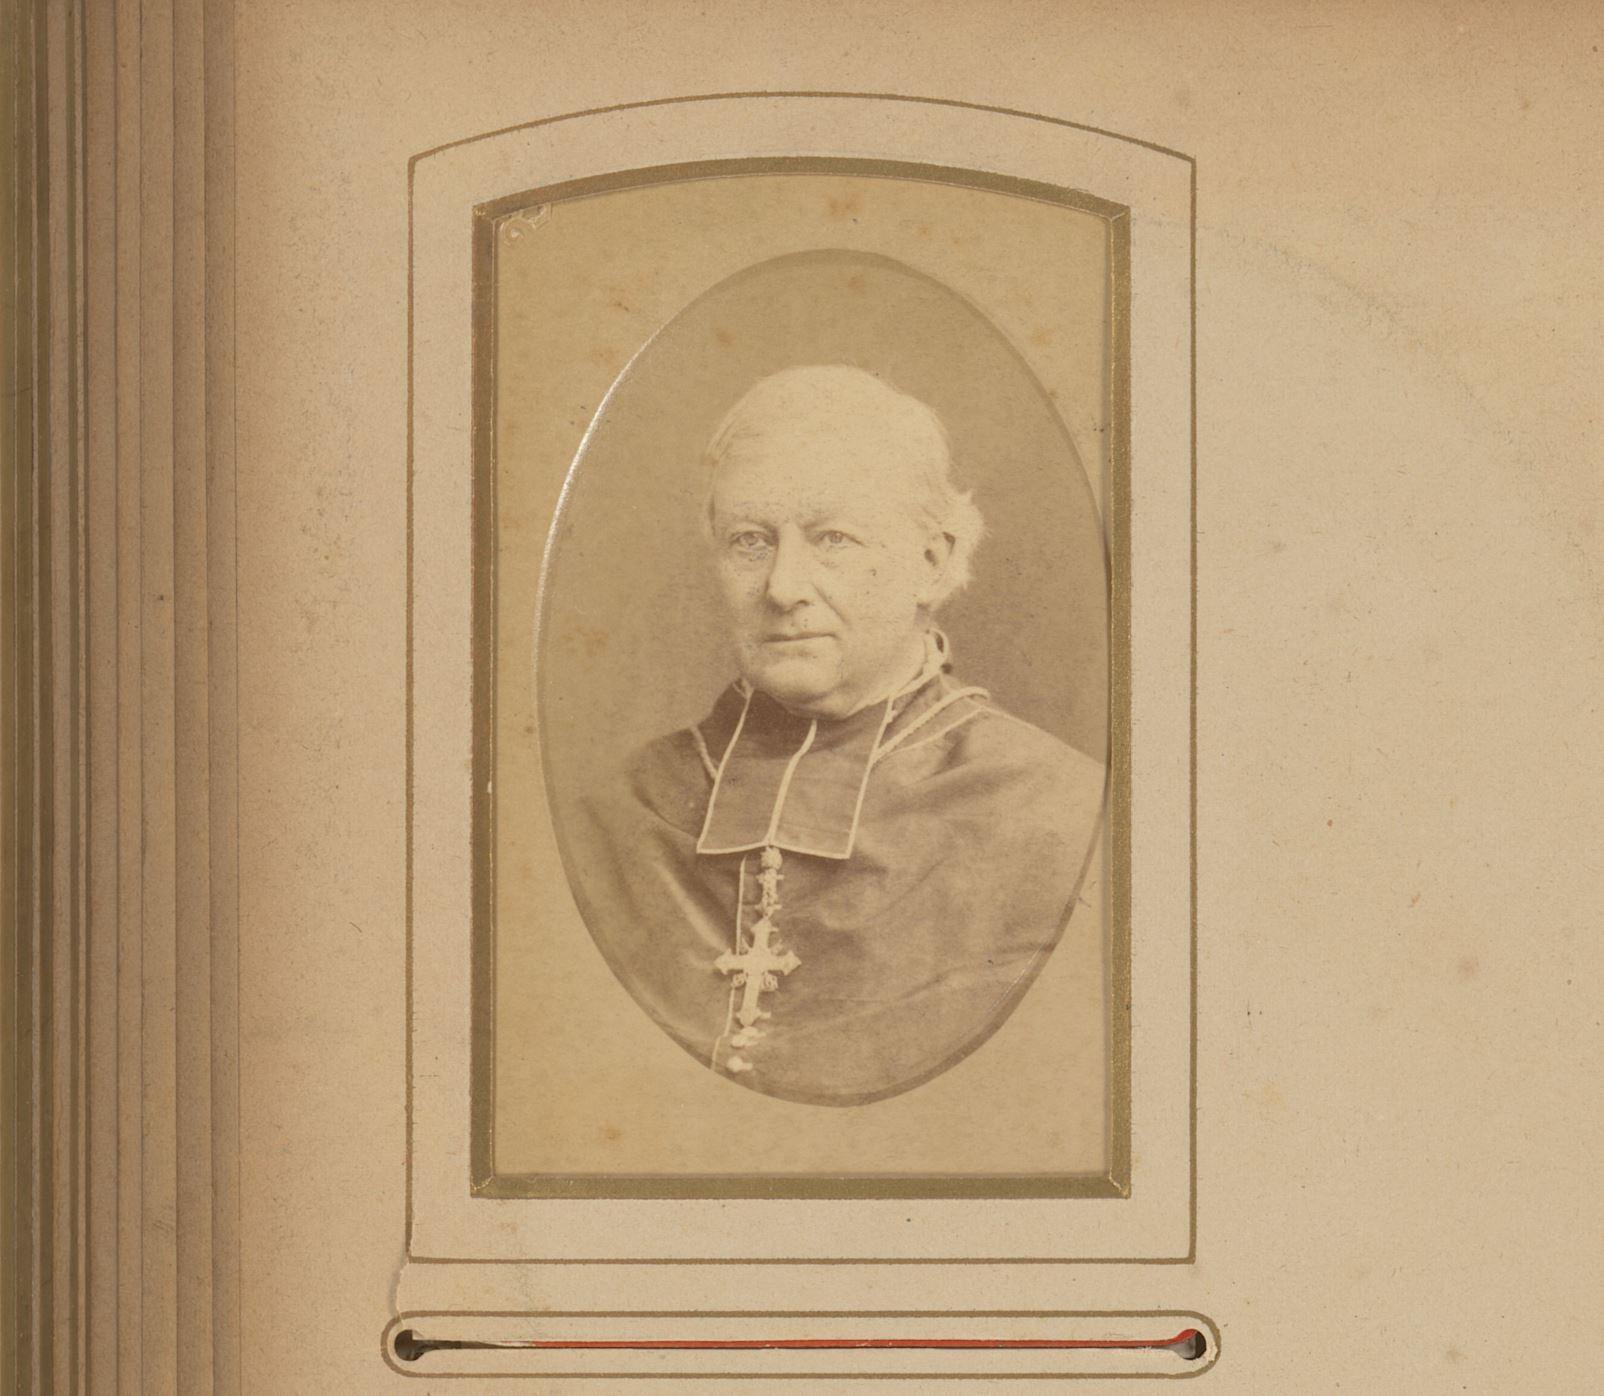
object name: album leaf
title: Portret van een geestelijke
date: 1872-1889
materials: cardboard, photographic support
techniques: albumen print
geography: ghent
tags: historical persons, organization, functionaries and dignitaries in roman catholic church; clergy in general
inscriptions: initials: ‘B’, inscription: ‘RUE DE LA VIGNE 16 HARENG PEC/ BEERNAERT/ FRÈRES/ GAND/ Tous les Clichés étant conservés on peut/ toujours en obtenir de nouvelles épreuves/ ainsi que e ceux de l'ancienne Photie Renoz’